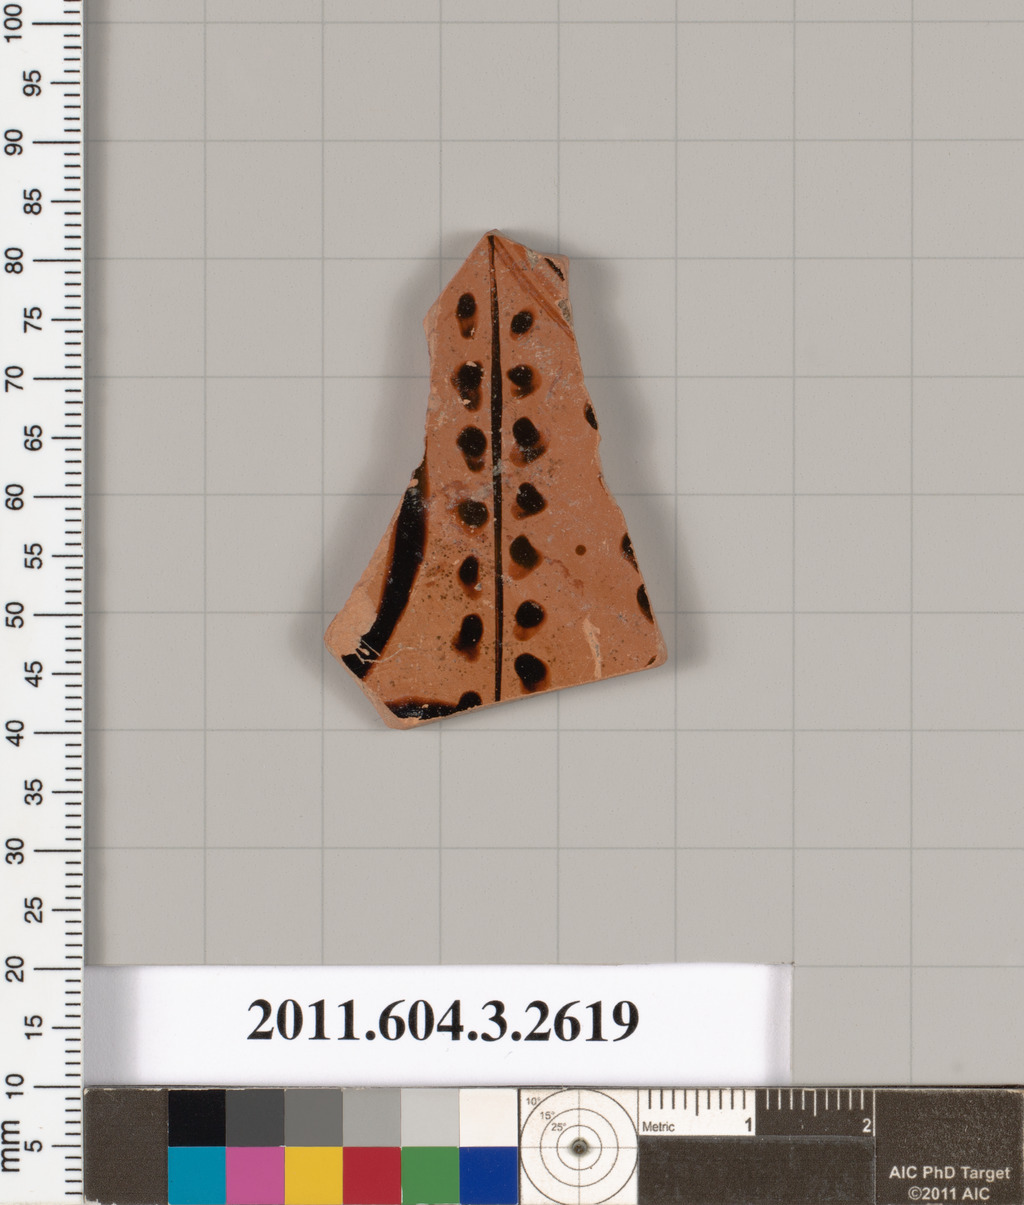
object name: kylix fragment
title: Terracotta fragment of a kylix (drinking cup)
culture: greek, attic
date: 525-501 BCE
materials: terracotta